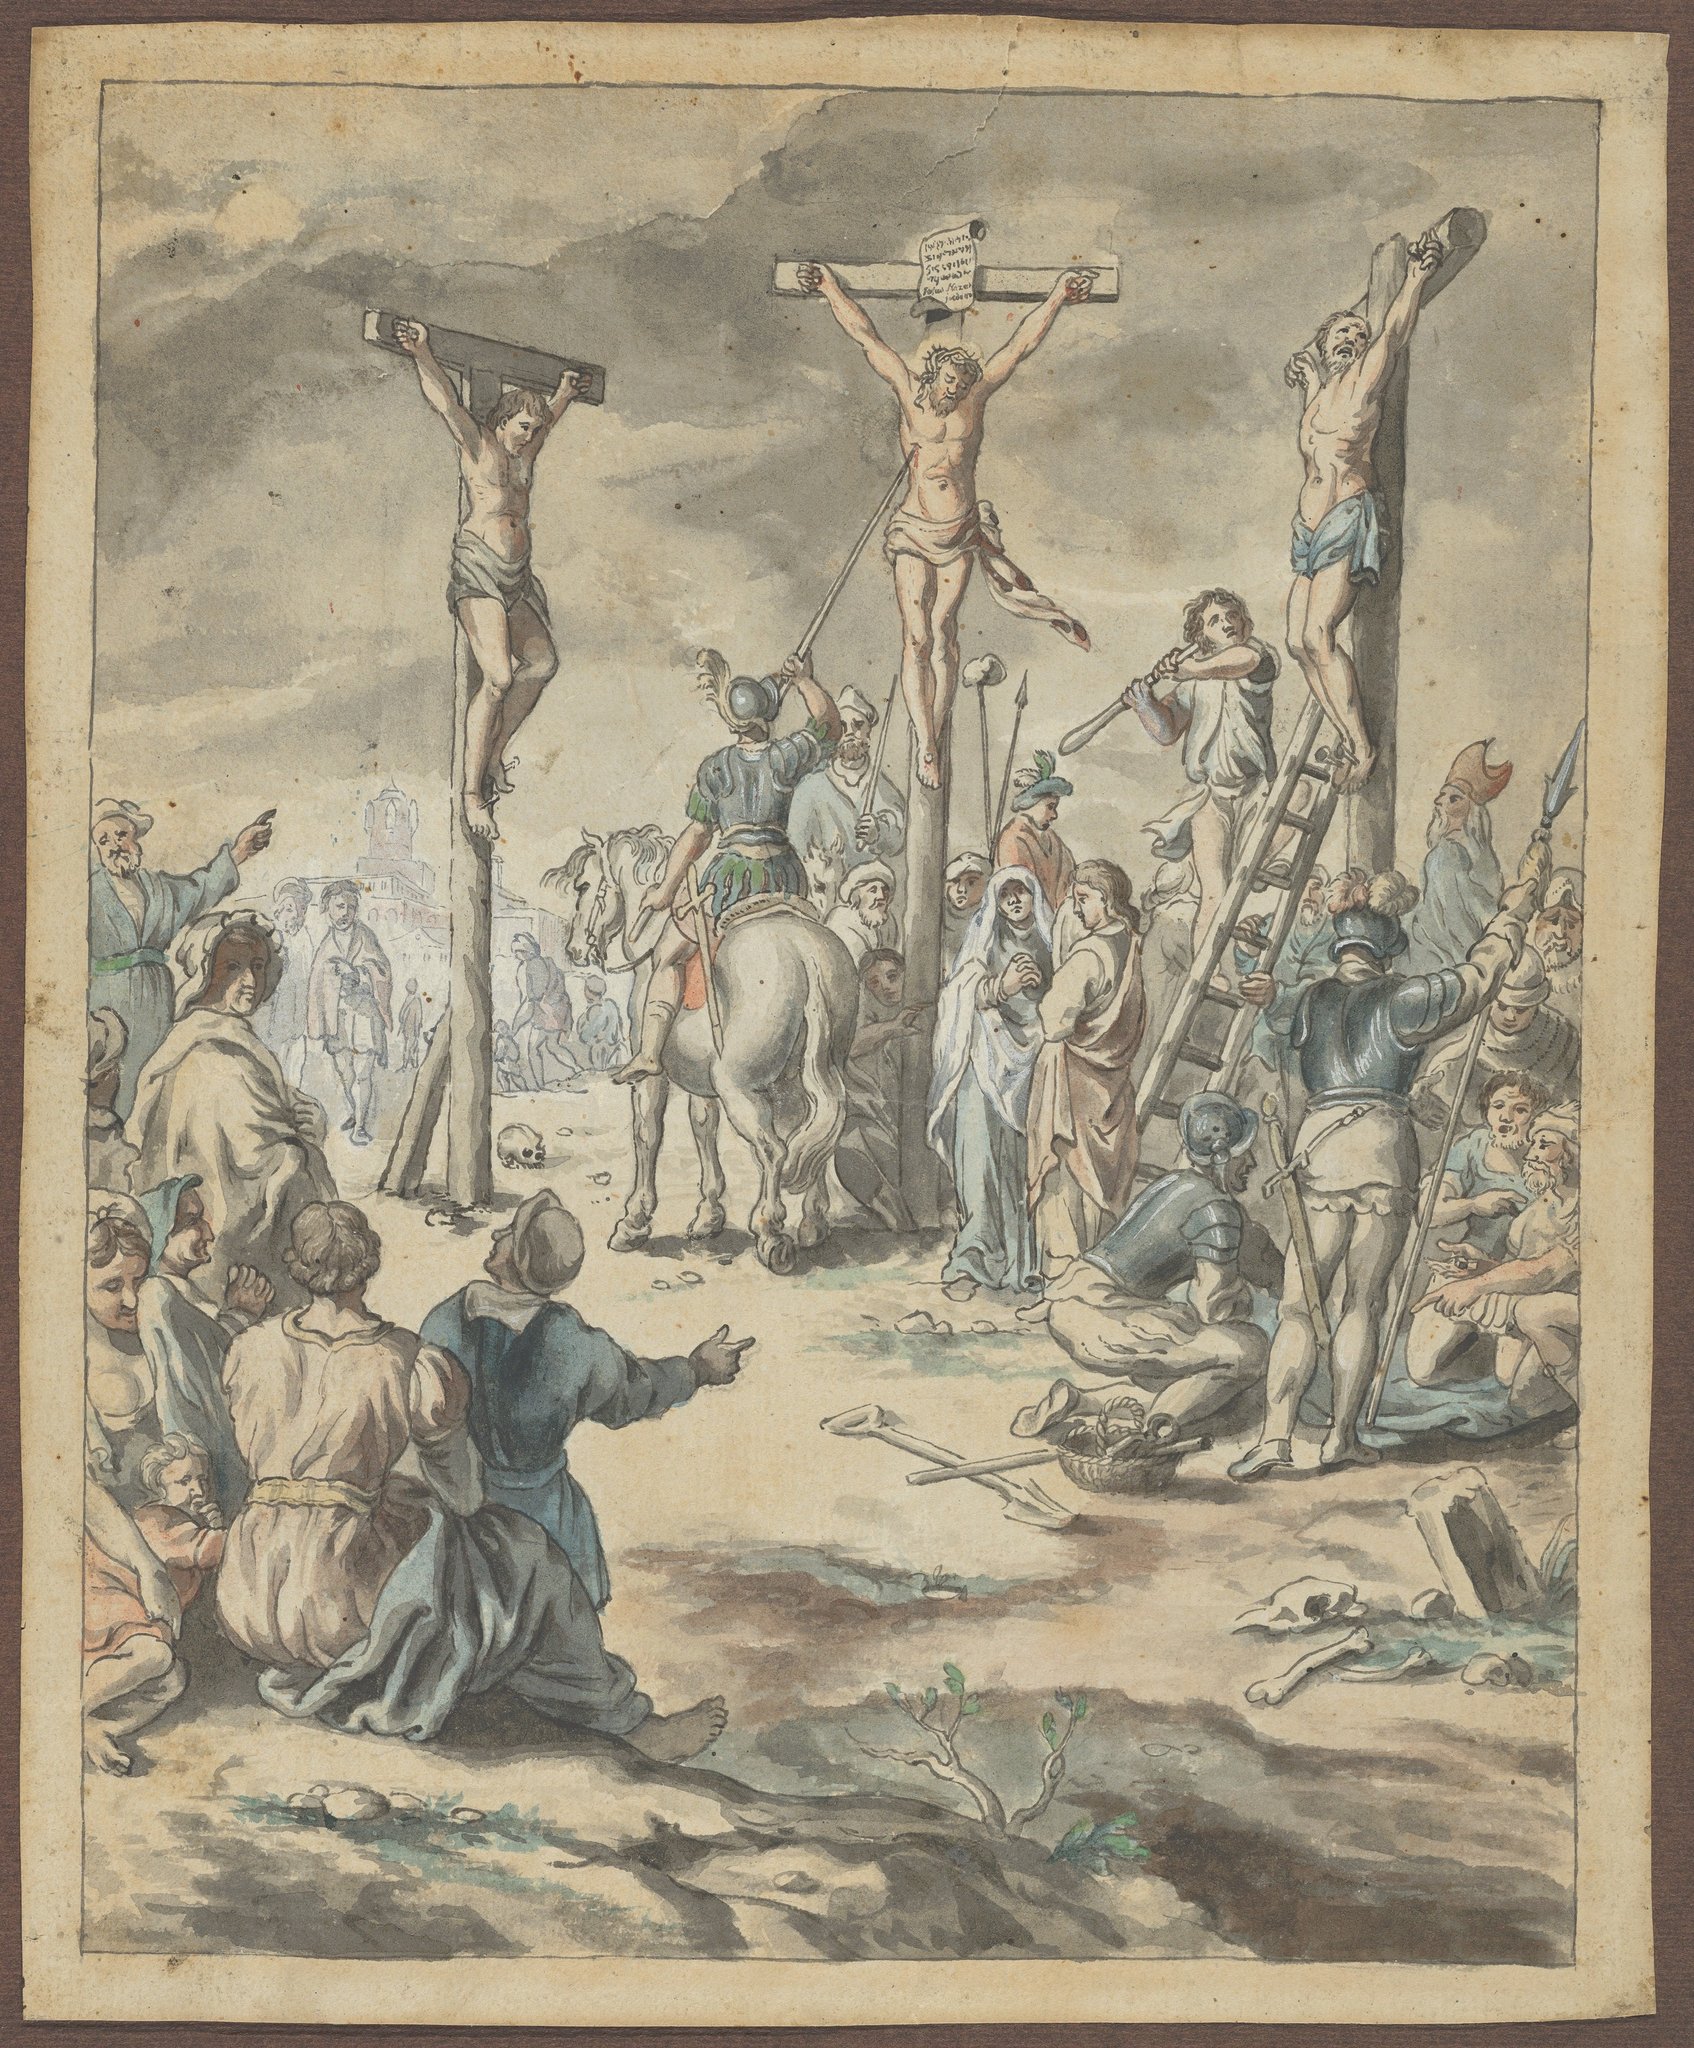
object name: drawing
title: The Crucifixion of Christ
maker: pehr hörberg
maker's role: artist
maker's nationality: swedish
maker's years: 1746-1816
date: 1767-1800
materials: gouache, ink, watercolor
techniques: heightening, pen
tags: men,horses,christ,crucifixion